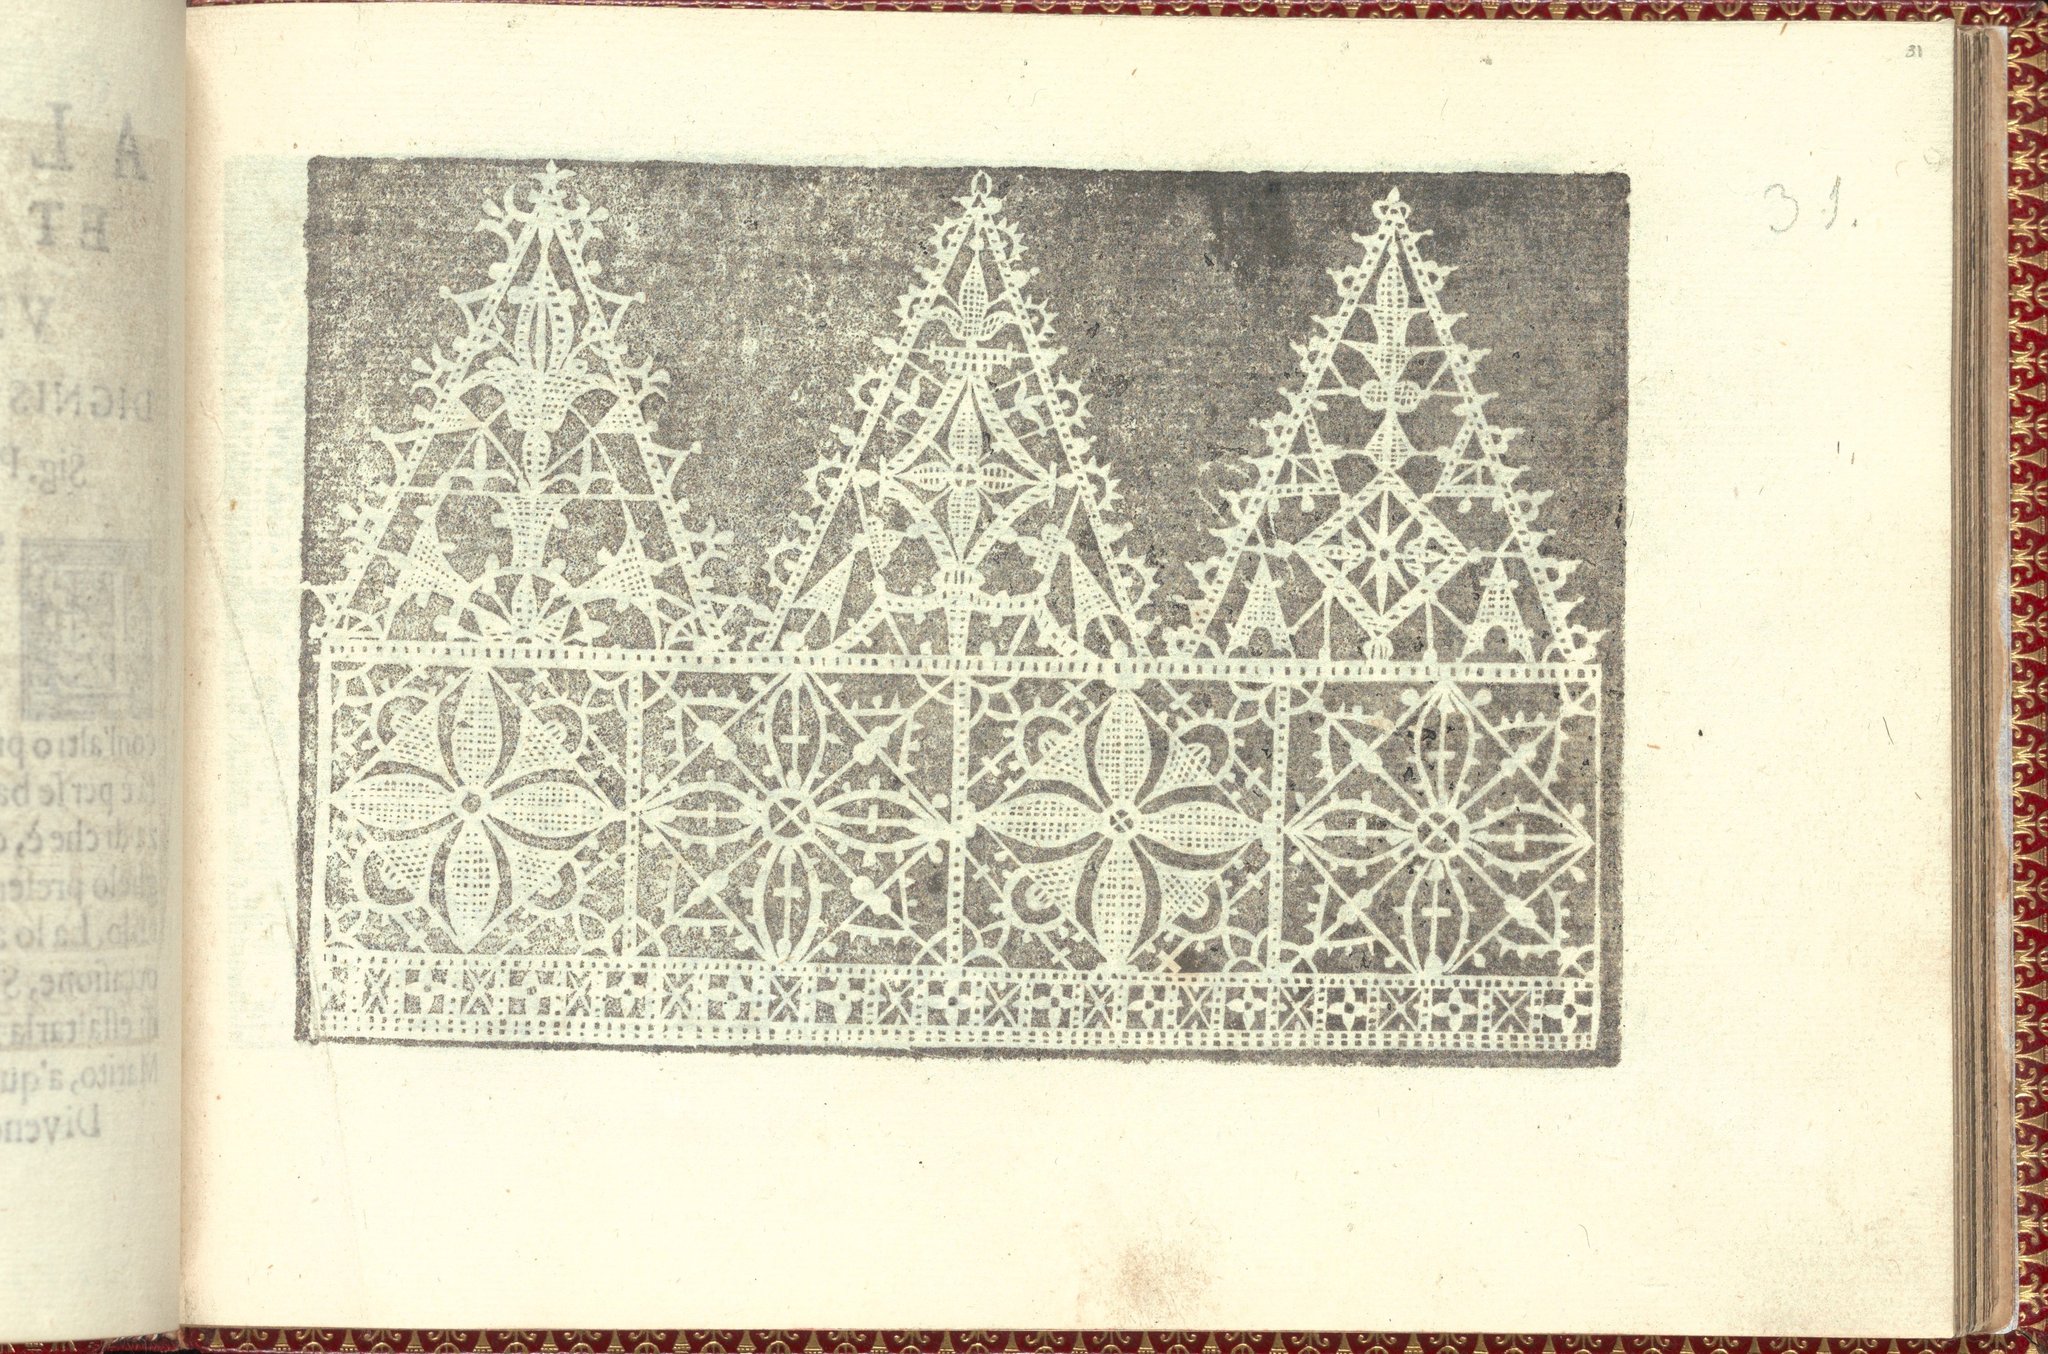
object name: book print ornament architecture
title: Corona delle Nobili et Virtuose Donne: Libro I-IV, page 31 (recto)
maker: cesare vecellio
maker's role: publisher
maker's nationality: italian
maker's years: 1521-1601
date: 1601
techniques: woodcut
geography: italy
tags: ornament